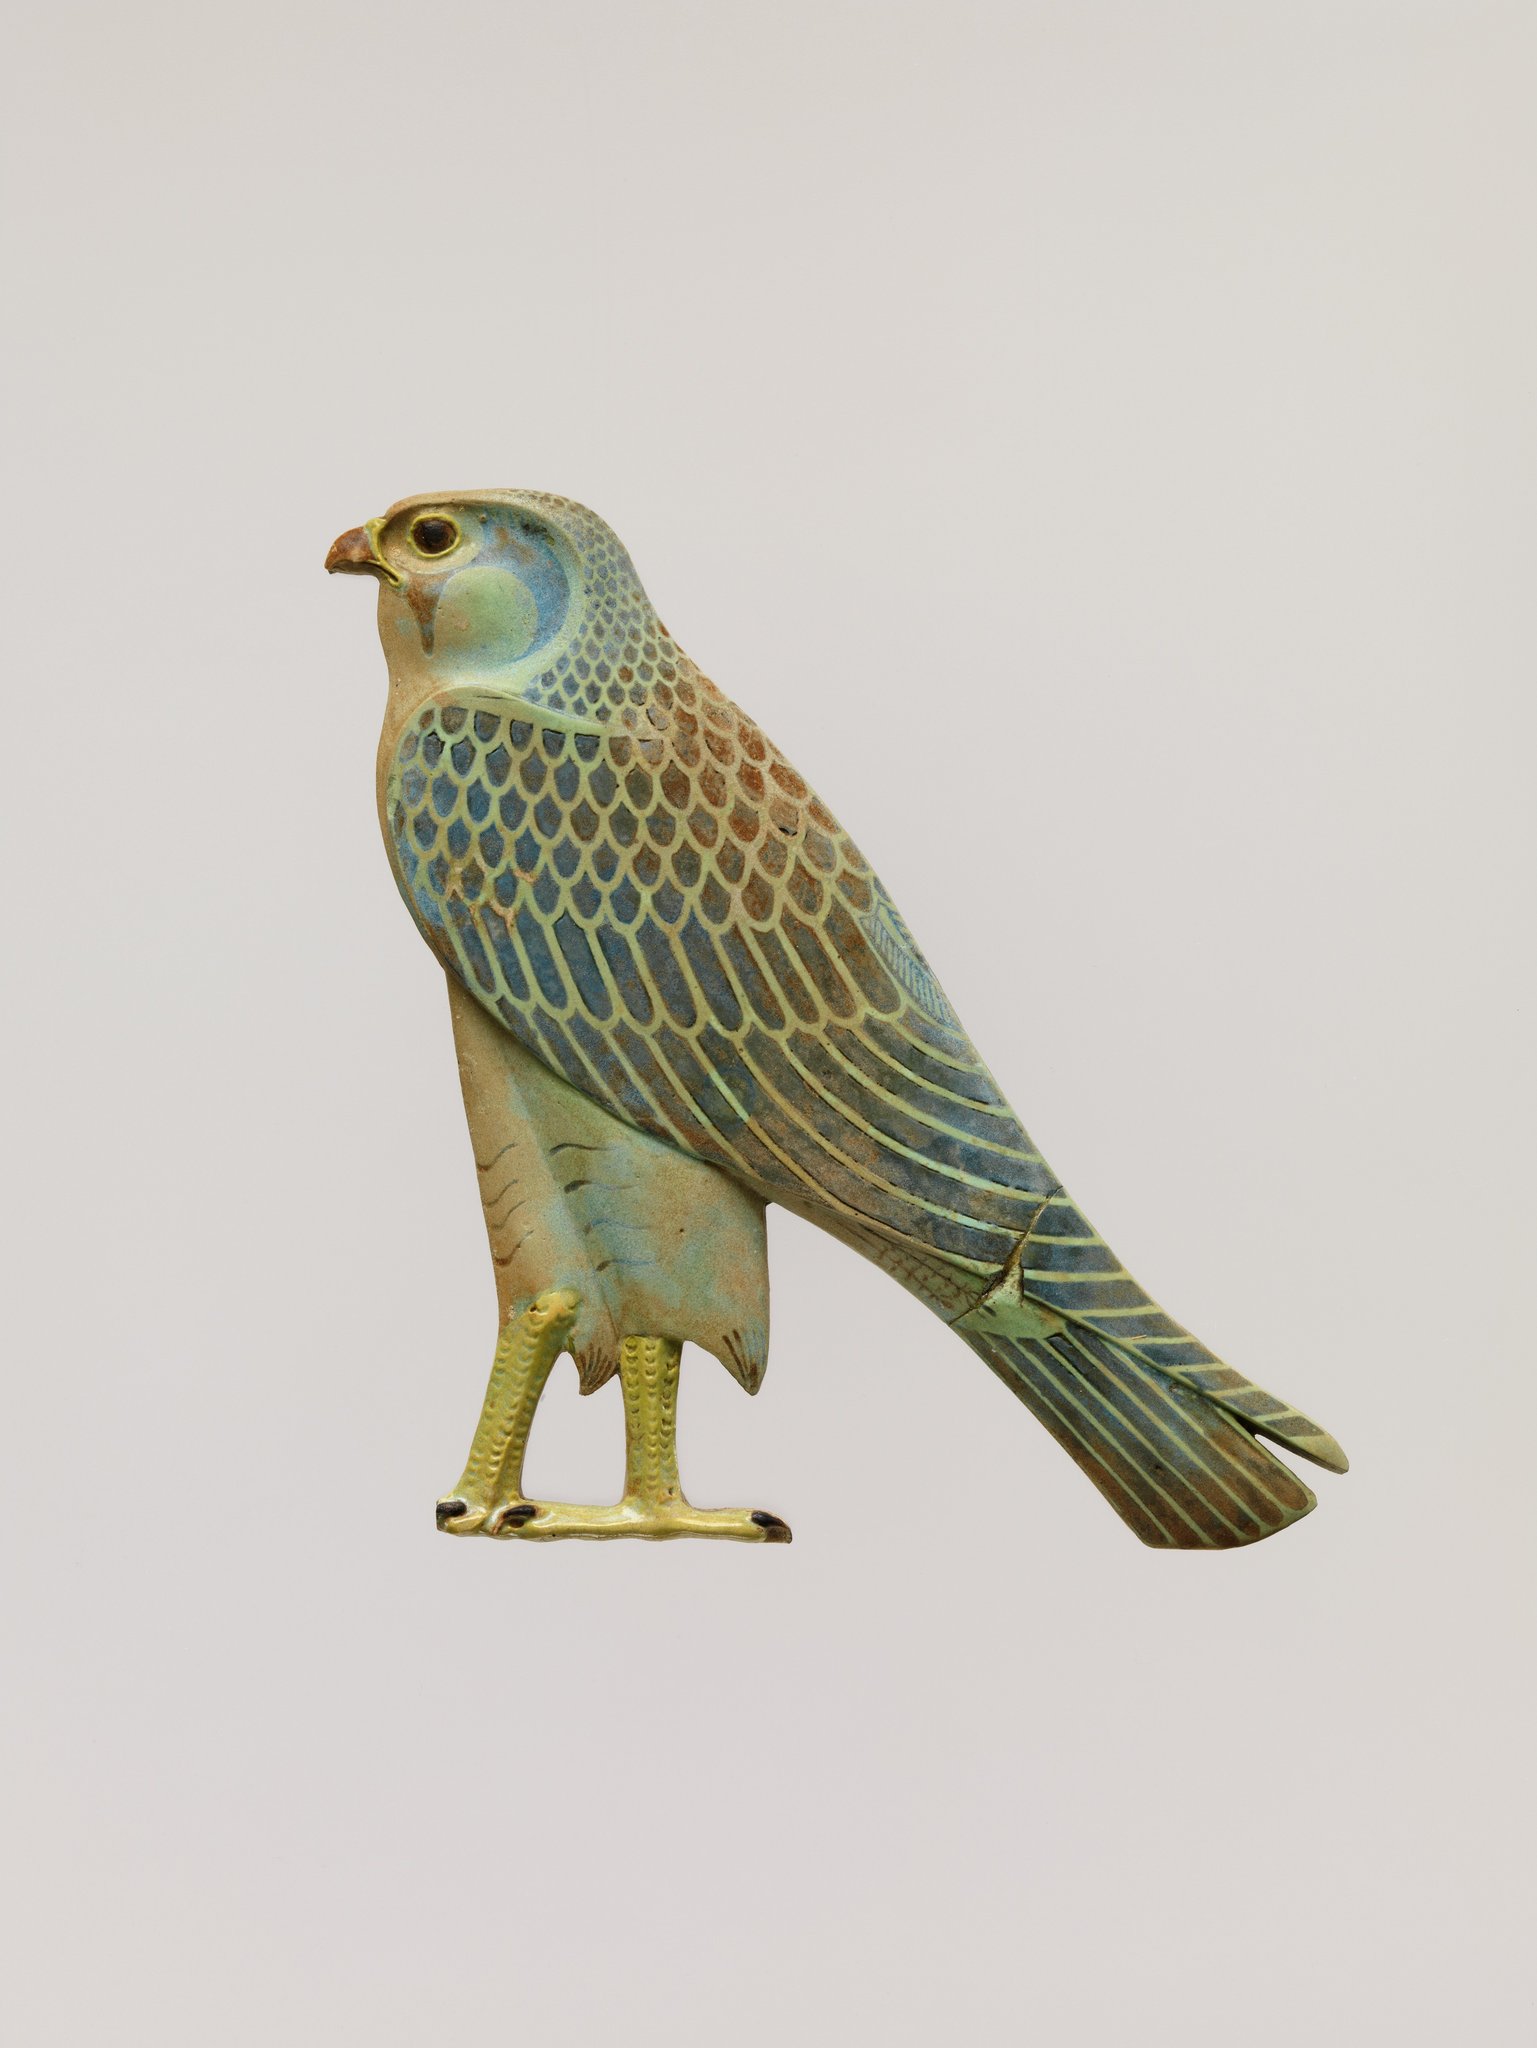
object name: inlay, falcon, horus falcon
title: Inlay in the form of the Horus falcon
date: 400-301 BCE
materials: faience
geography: middle egypt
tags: falcons,horus